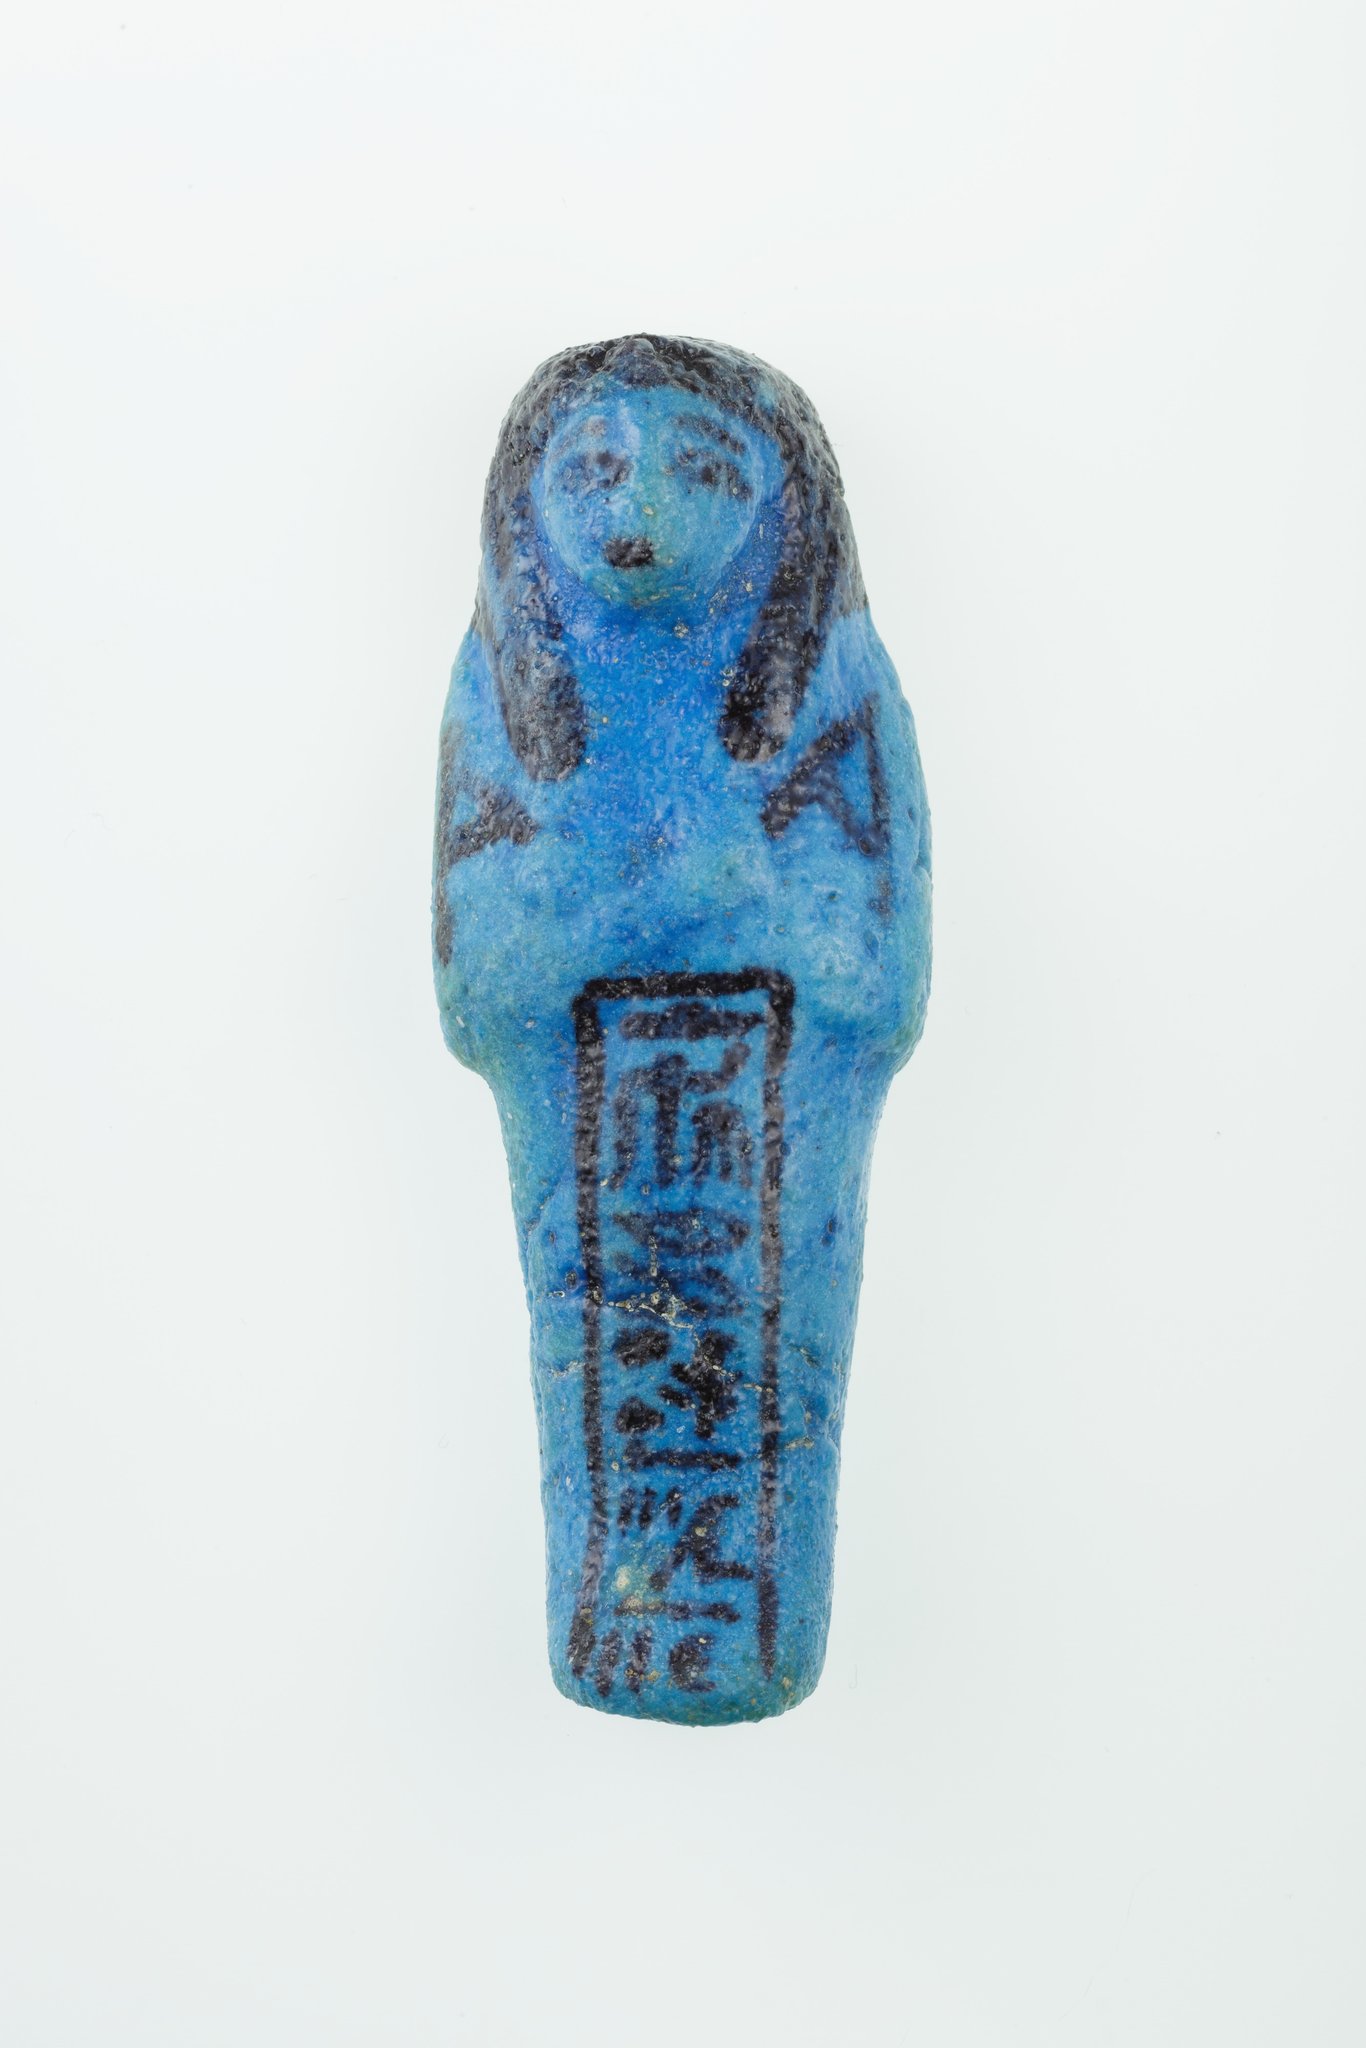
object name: shabti, worker, nauny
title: Worker Shabti of Nauny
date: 1050 BCE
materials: faience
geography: egypt